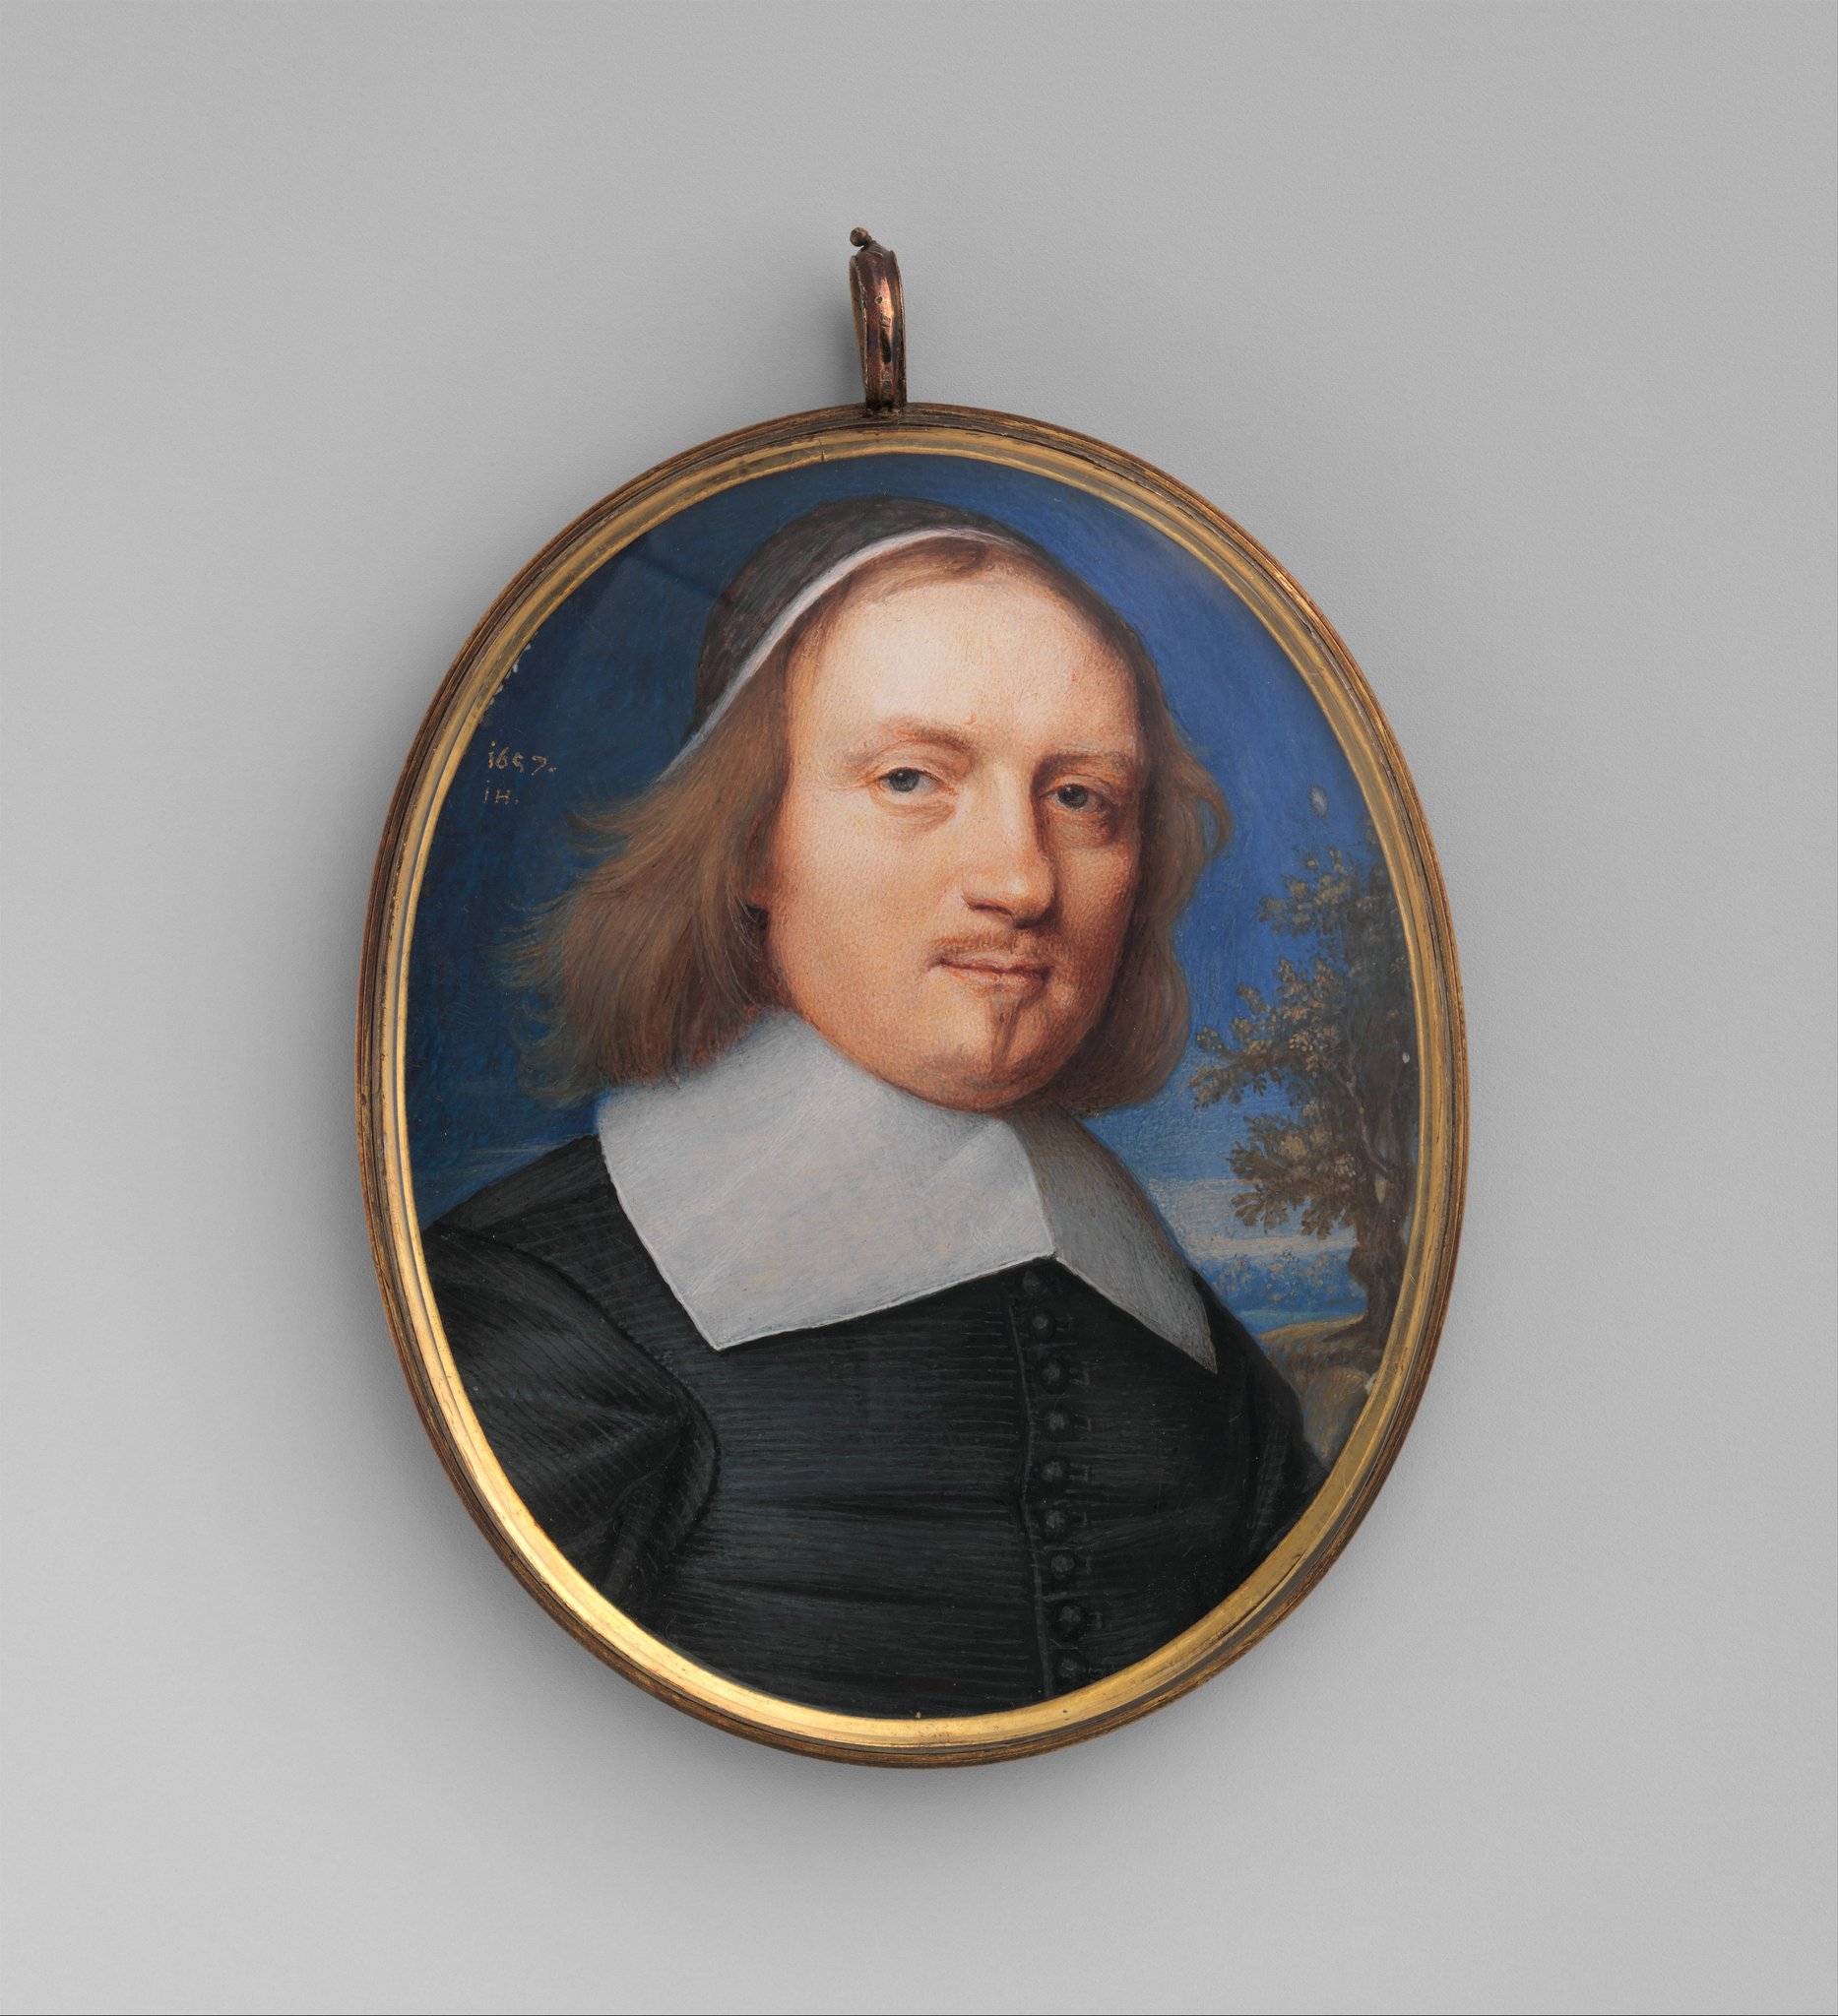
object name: painting, miniature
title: Dr. Brian Walton (born about 1600, died 1661)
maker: john hoskins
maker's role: artist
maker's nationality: british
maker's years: 1615-1665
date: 1657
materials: parchment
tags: men,portraits